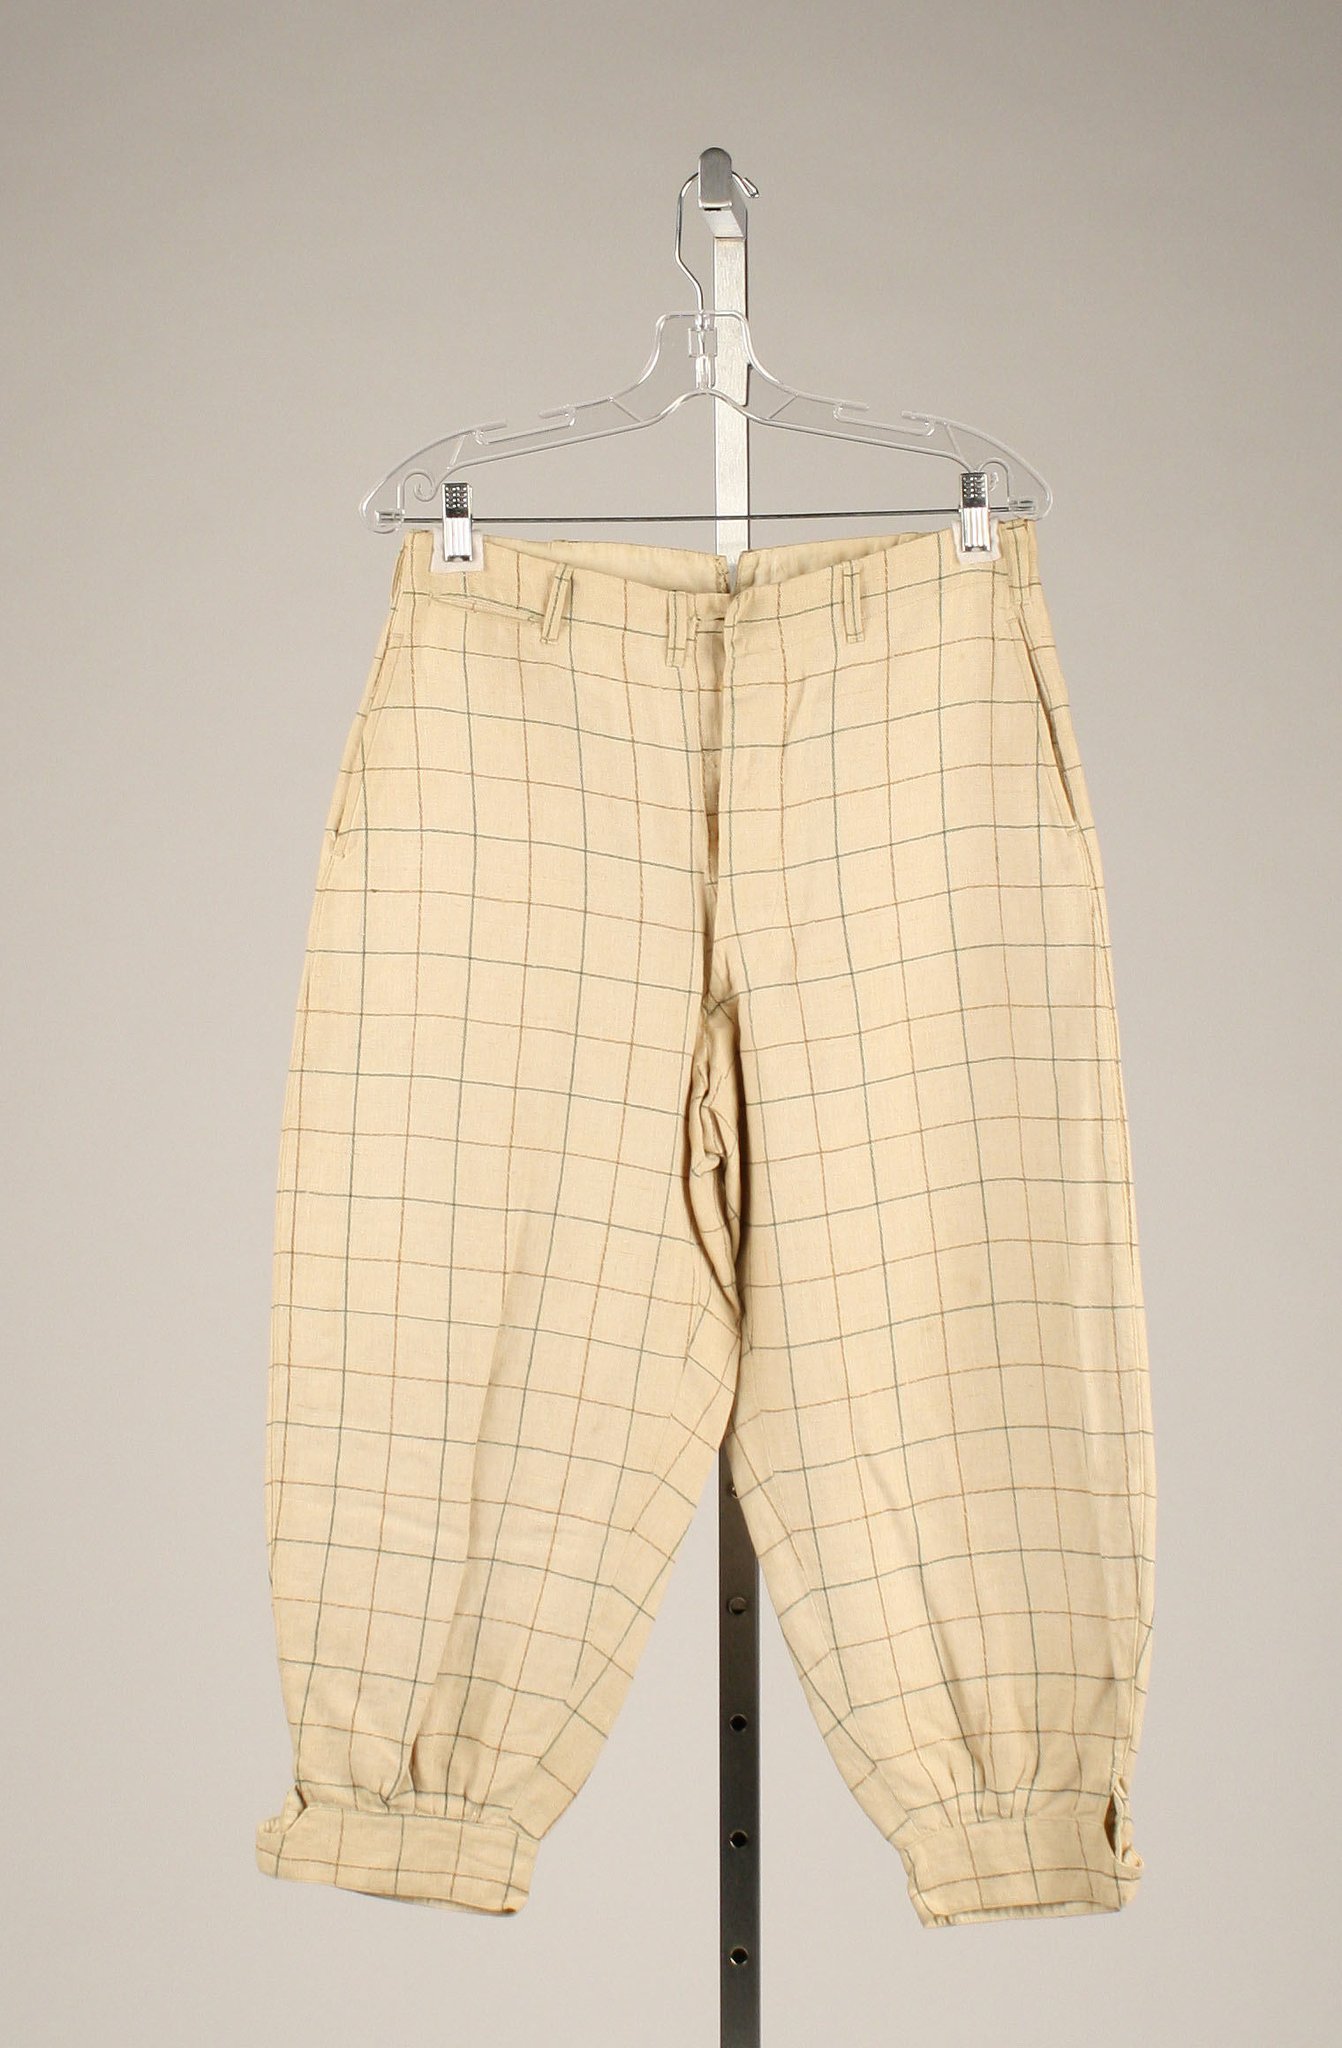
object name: knickerbockers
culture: american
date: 1900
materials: linen